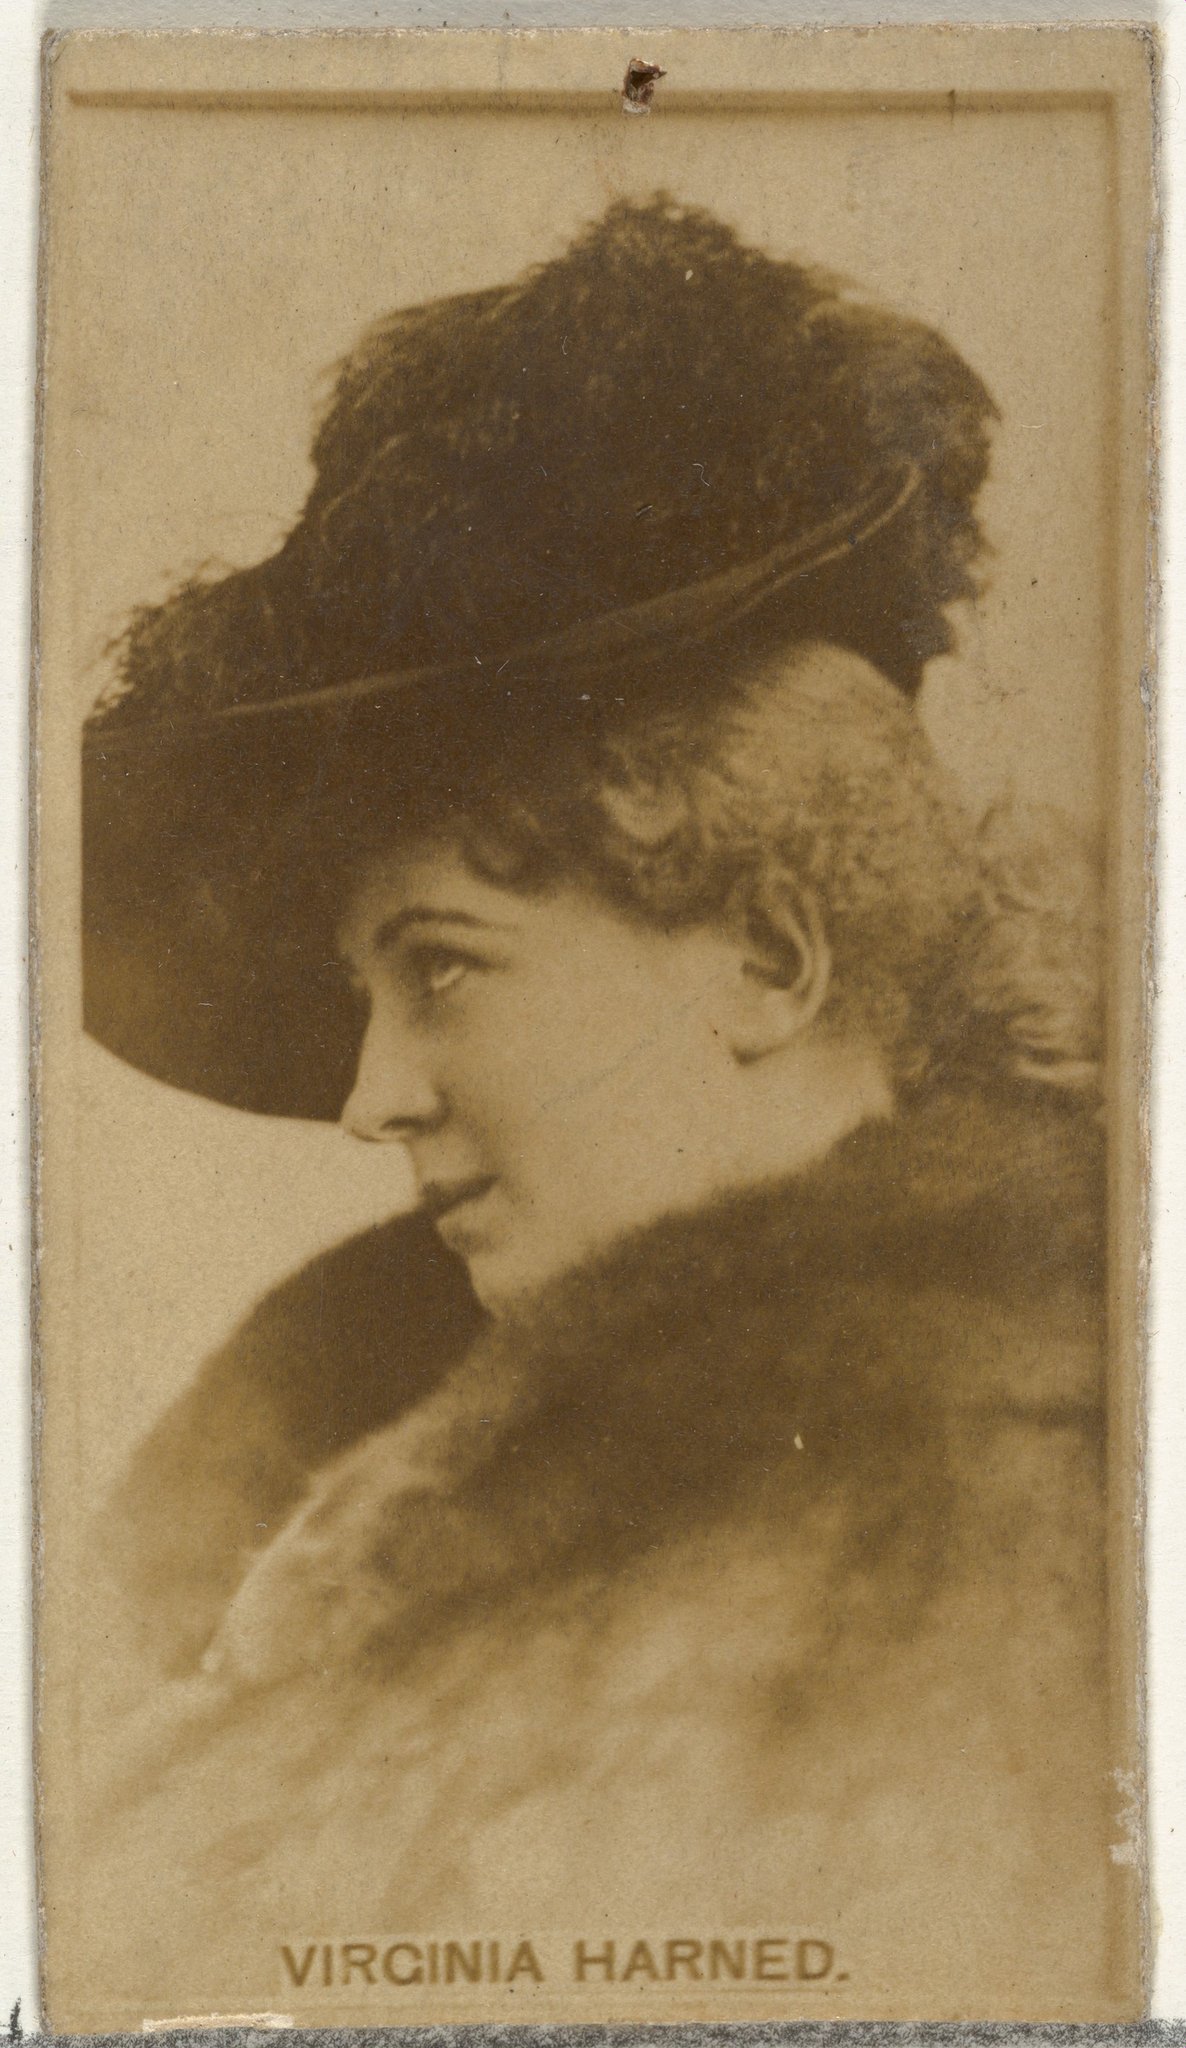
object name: photograph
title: Virginia Harned, from the Actors and Actresses series (N145-8) issued by Duke Sons & Co. to promote Duke Cigarettes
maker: w. duke, sons & co.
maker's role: publisher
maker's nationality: american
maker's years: 1870-1920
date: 1891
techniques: albumen silver print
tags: portraits,women,actresses